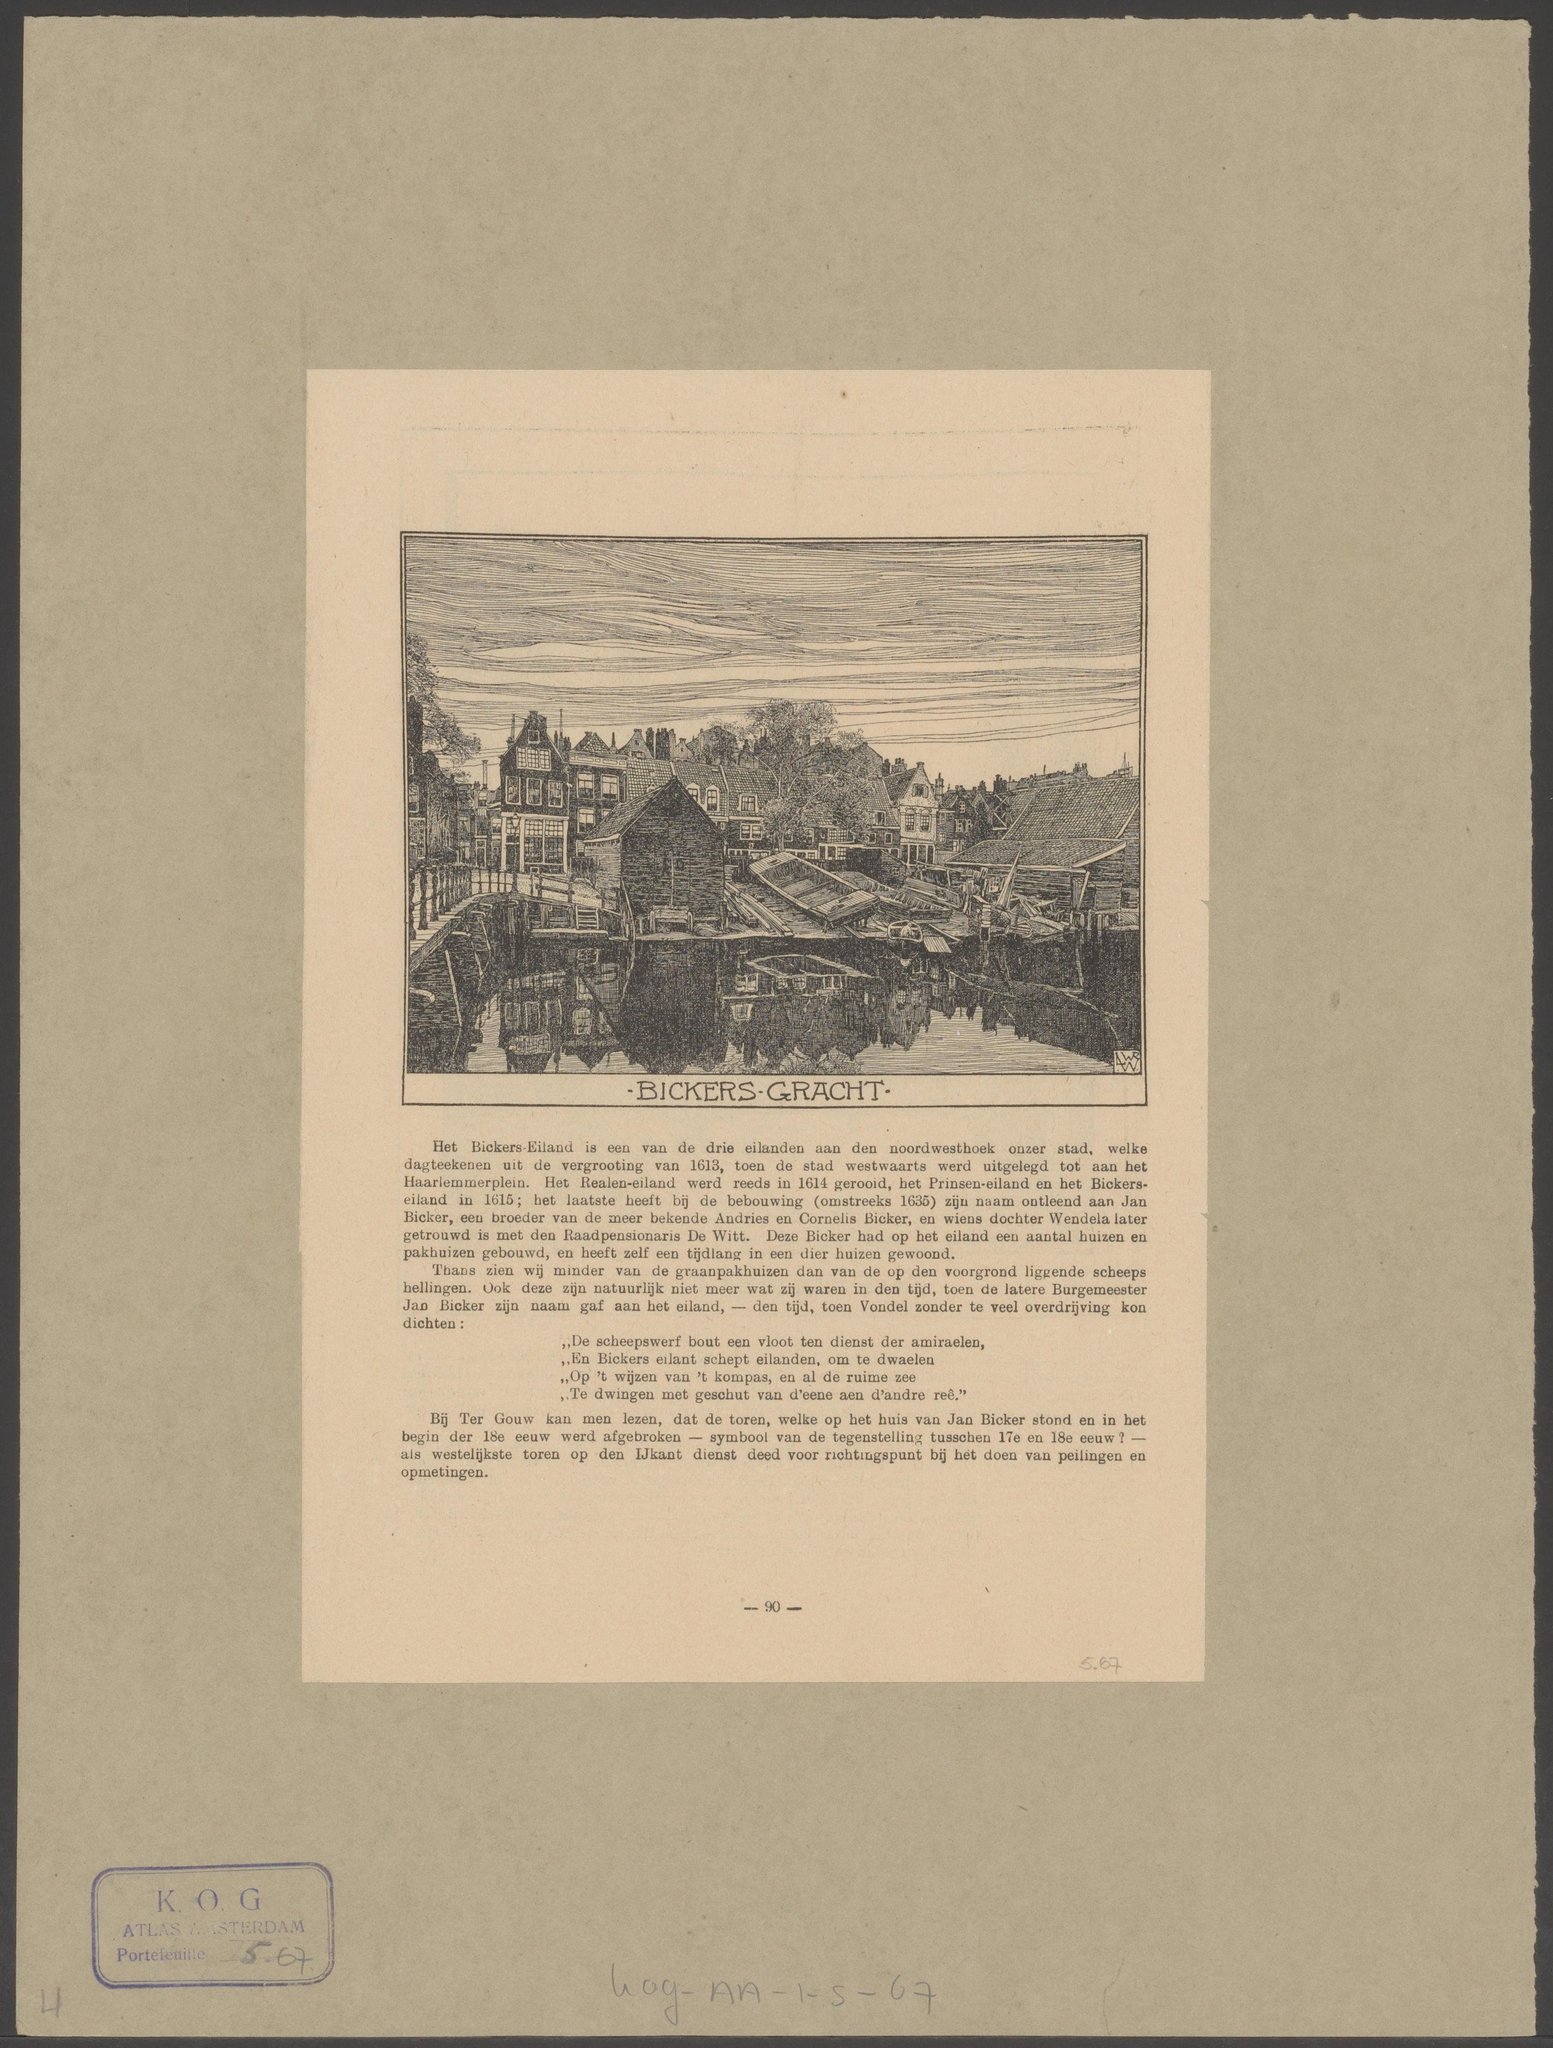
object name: photomechanical print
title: Oud-Amsterdam 100 Stadsgezichten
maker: willem wenckebach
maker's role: designer, draughtsman, painter, print maker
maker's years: 1860-1937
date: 1870-1923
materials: paper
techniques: letterpress printing, line block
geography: amsterdam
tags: city-view in general; 'veduta', canal, pier, quay, wharf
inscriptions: collector's mark: ‘5.67’ Lugt 1641b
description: Onderwerpsrubriek binnen de Atlas Amsterdam: Begijnensloot (Gedempte), Bagijnhofsteeg, Beulingsloot, Bickersgracht en –plein, Bickersstraat (Groote), Bilderdijkskade en -straat, Binnenkant, Blauwburgwal, Boomdwarsstraat, Brouwersgracht, Bleekersspad (Lange), Bleekerssloot, Bloemgracht, Boerenwetering, Boltensgrachtje, Boomssloot (Recht), Badhuisweg.